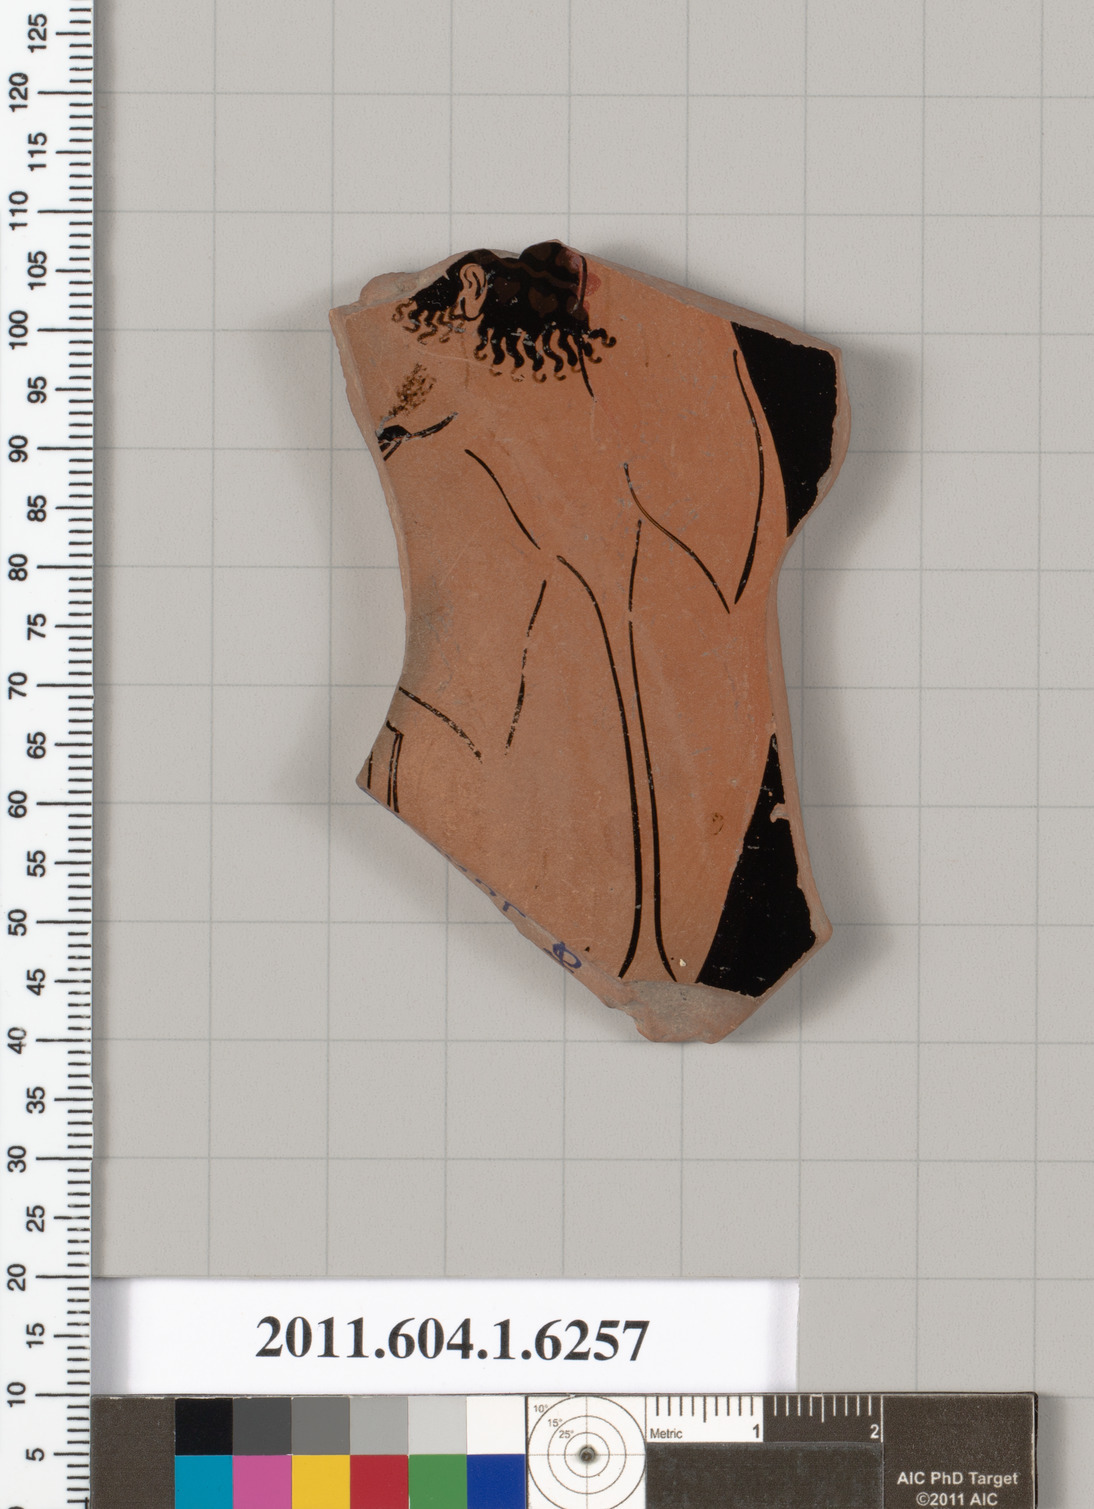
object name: kylix fragment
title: Terracotta fragment of a kylix (drinking cup)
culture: greek, attic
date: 500-480 BCE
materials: terracotta